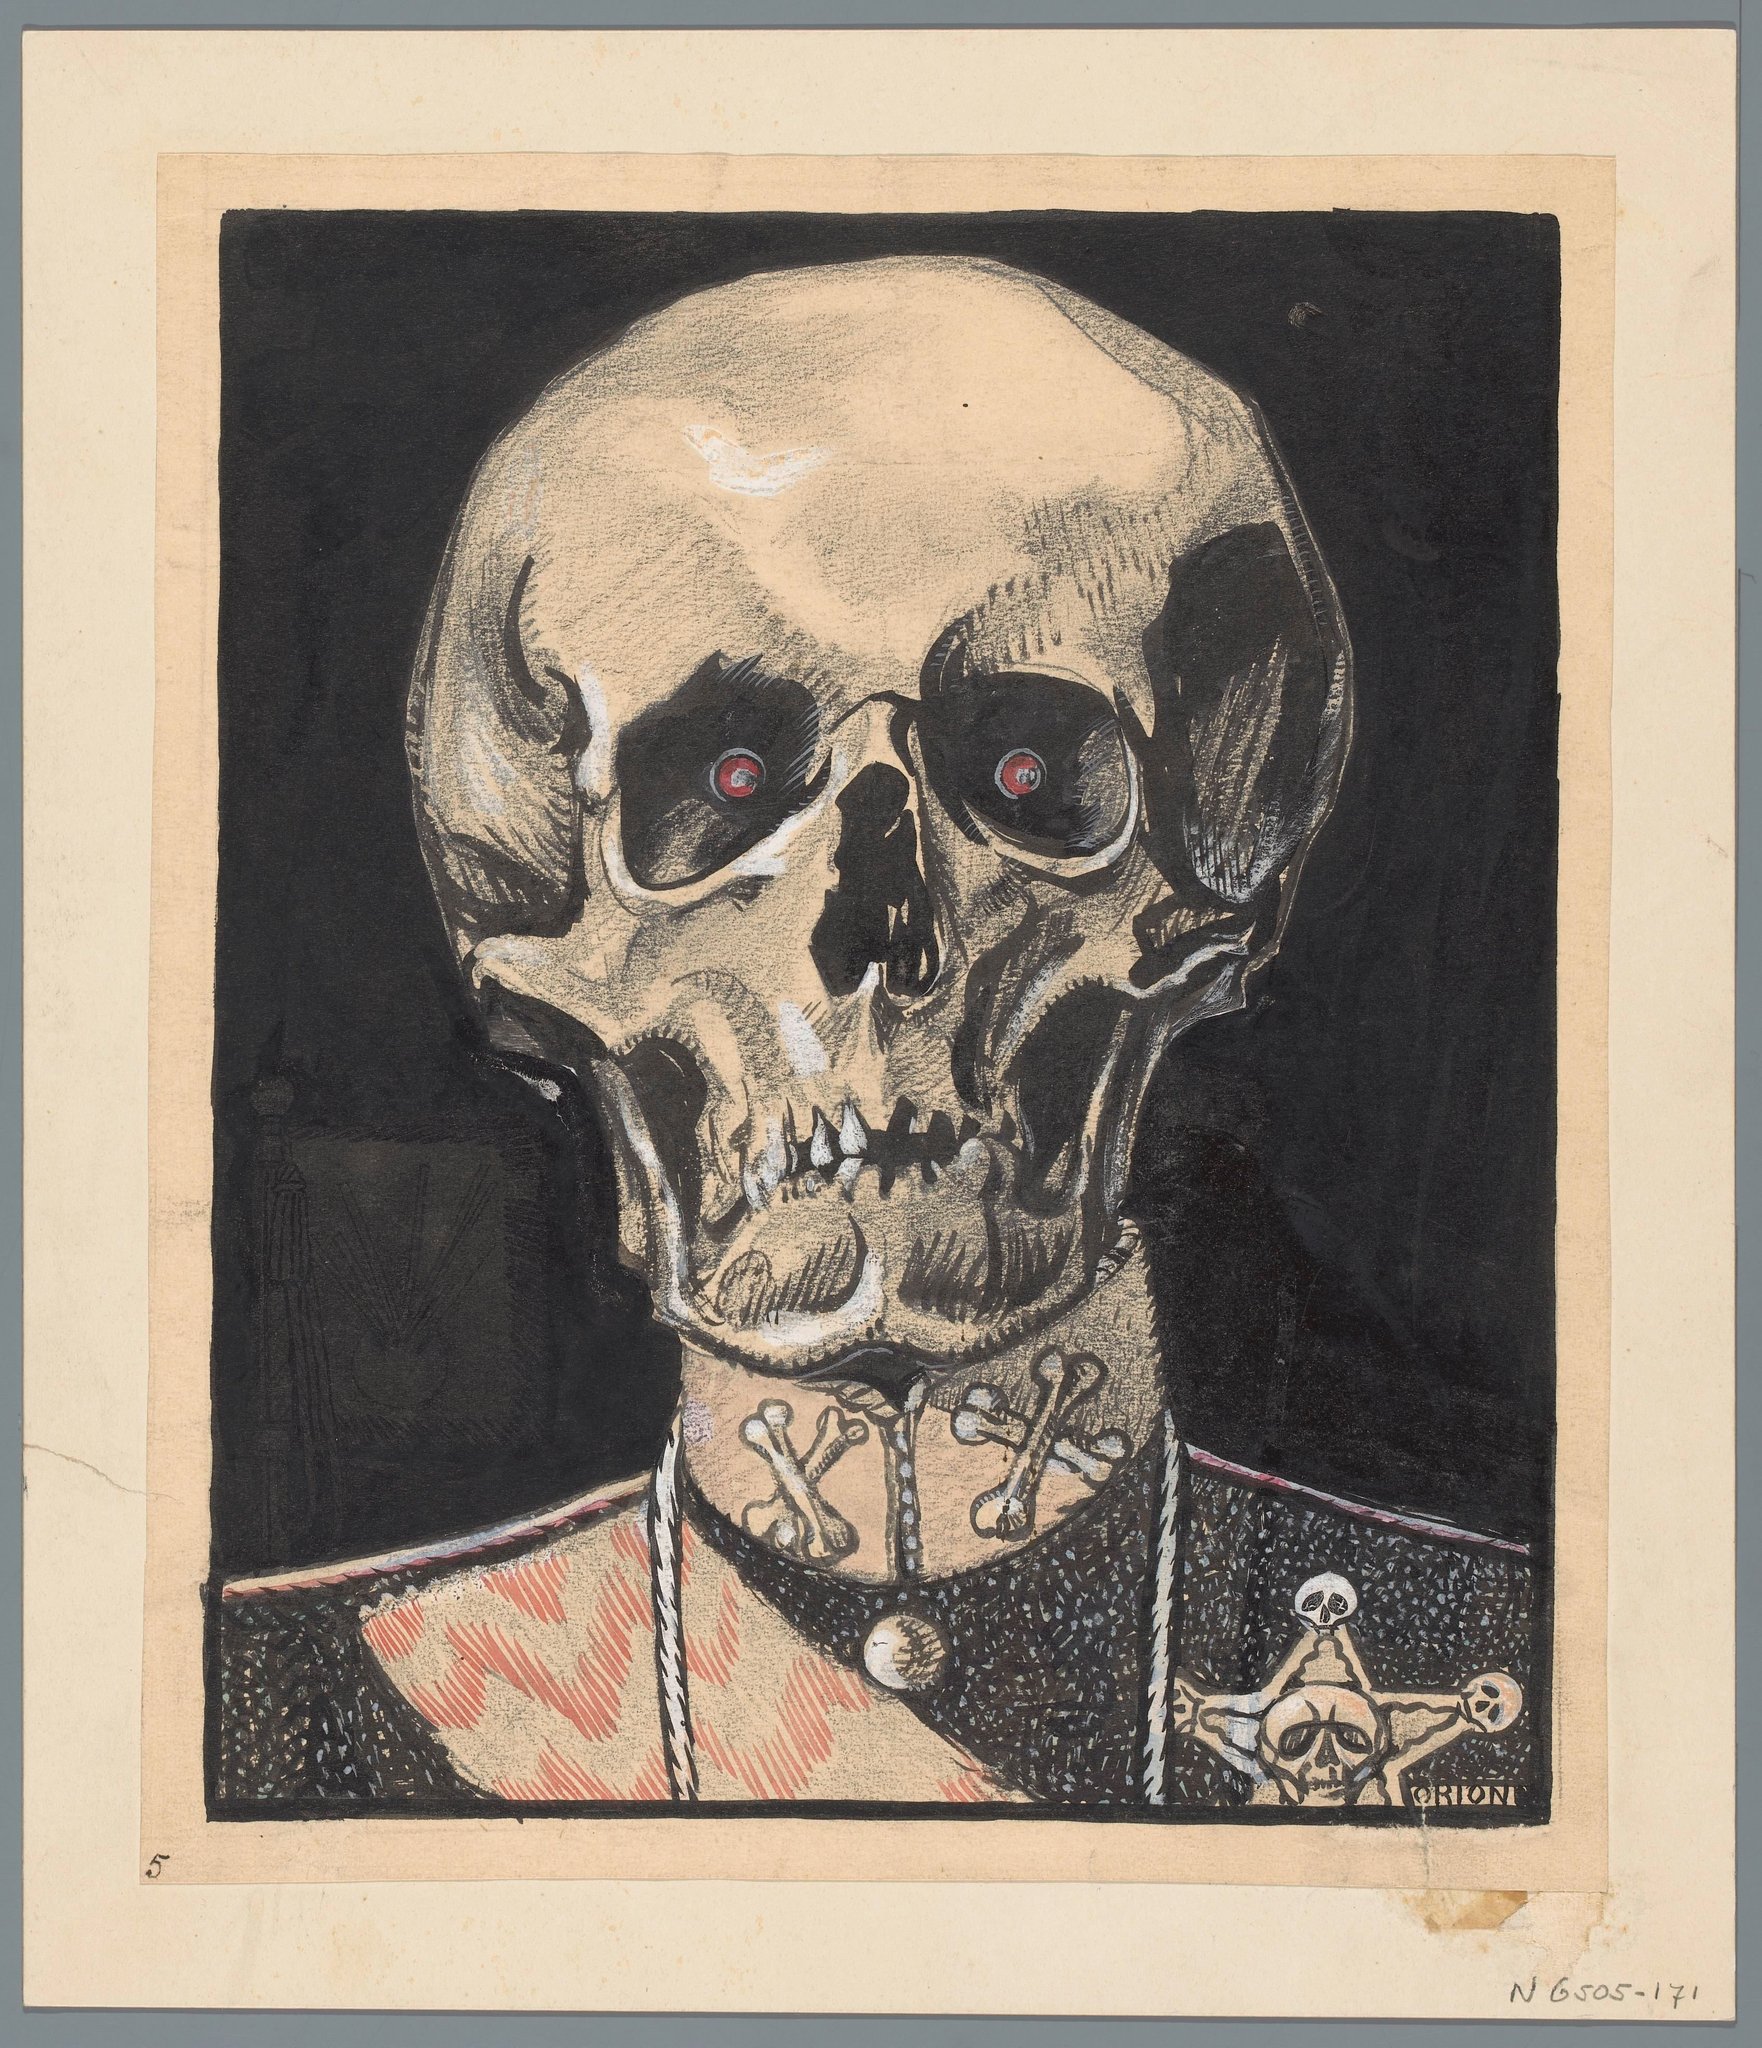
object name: drawing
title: Der Oberste Friedensstifter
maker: patricq kroon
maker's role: draughtsman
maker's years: 1862-1941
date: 1920-1935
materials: chalk, ink, paint, paper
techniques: brush, pen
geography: netherlands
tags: personifications of death; 'morte' (ripa), political caricatures and satires, germany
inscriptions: inscription: ‘5 Der Oberste Friedensstifter’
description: De Dood in uniform als een Duitse vredesstichter. Ontwerp voor een politieke spotprent.